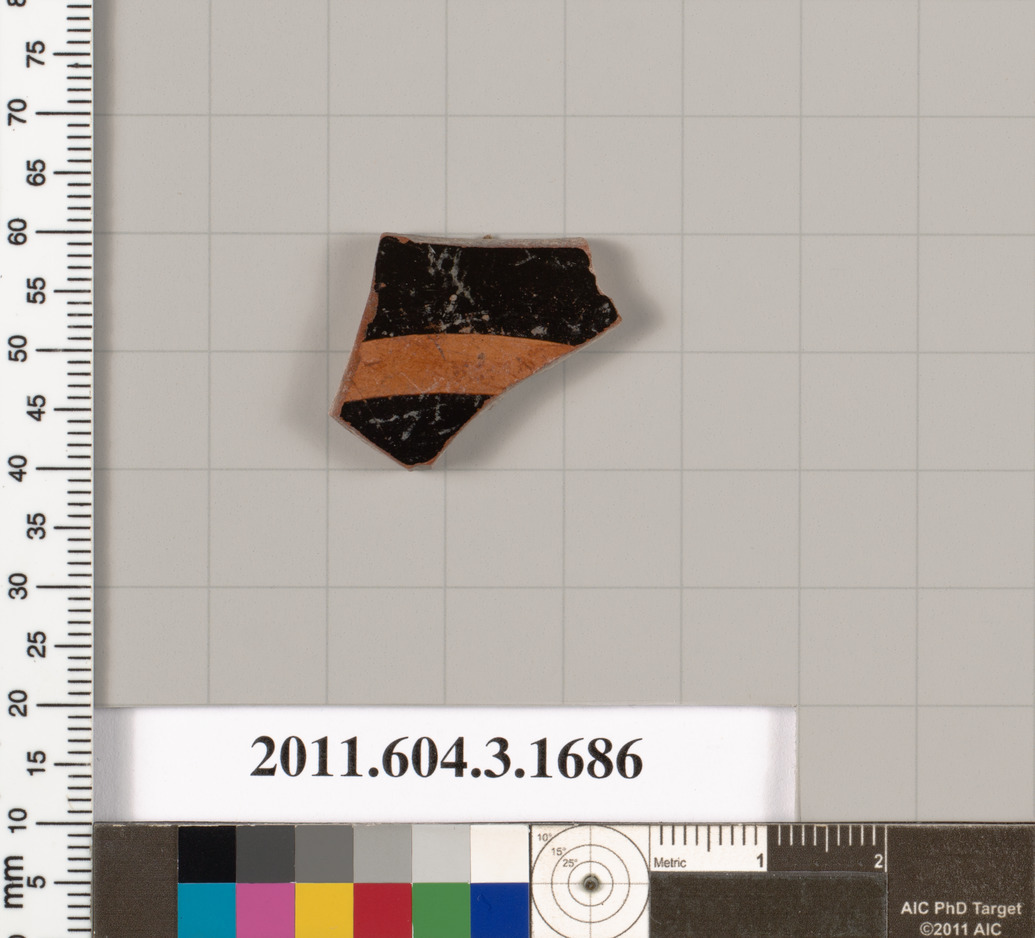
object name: kylix fragment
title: Terracotta fragment of a kylix: Band or lip cup (drinking cup)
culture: greek, attic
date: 550-526 BCE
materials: terracotta